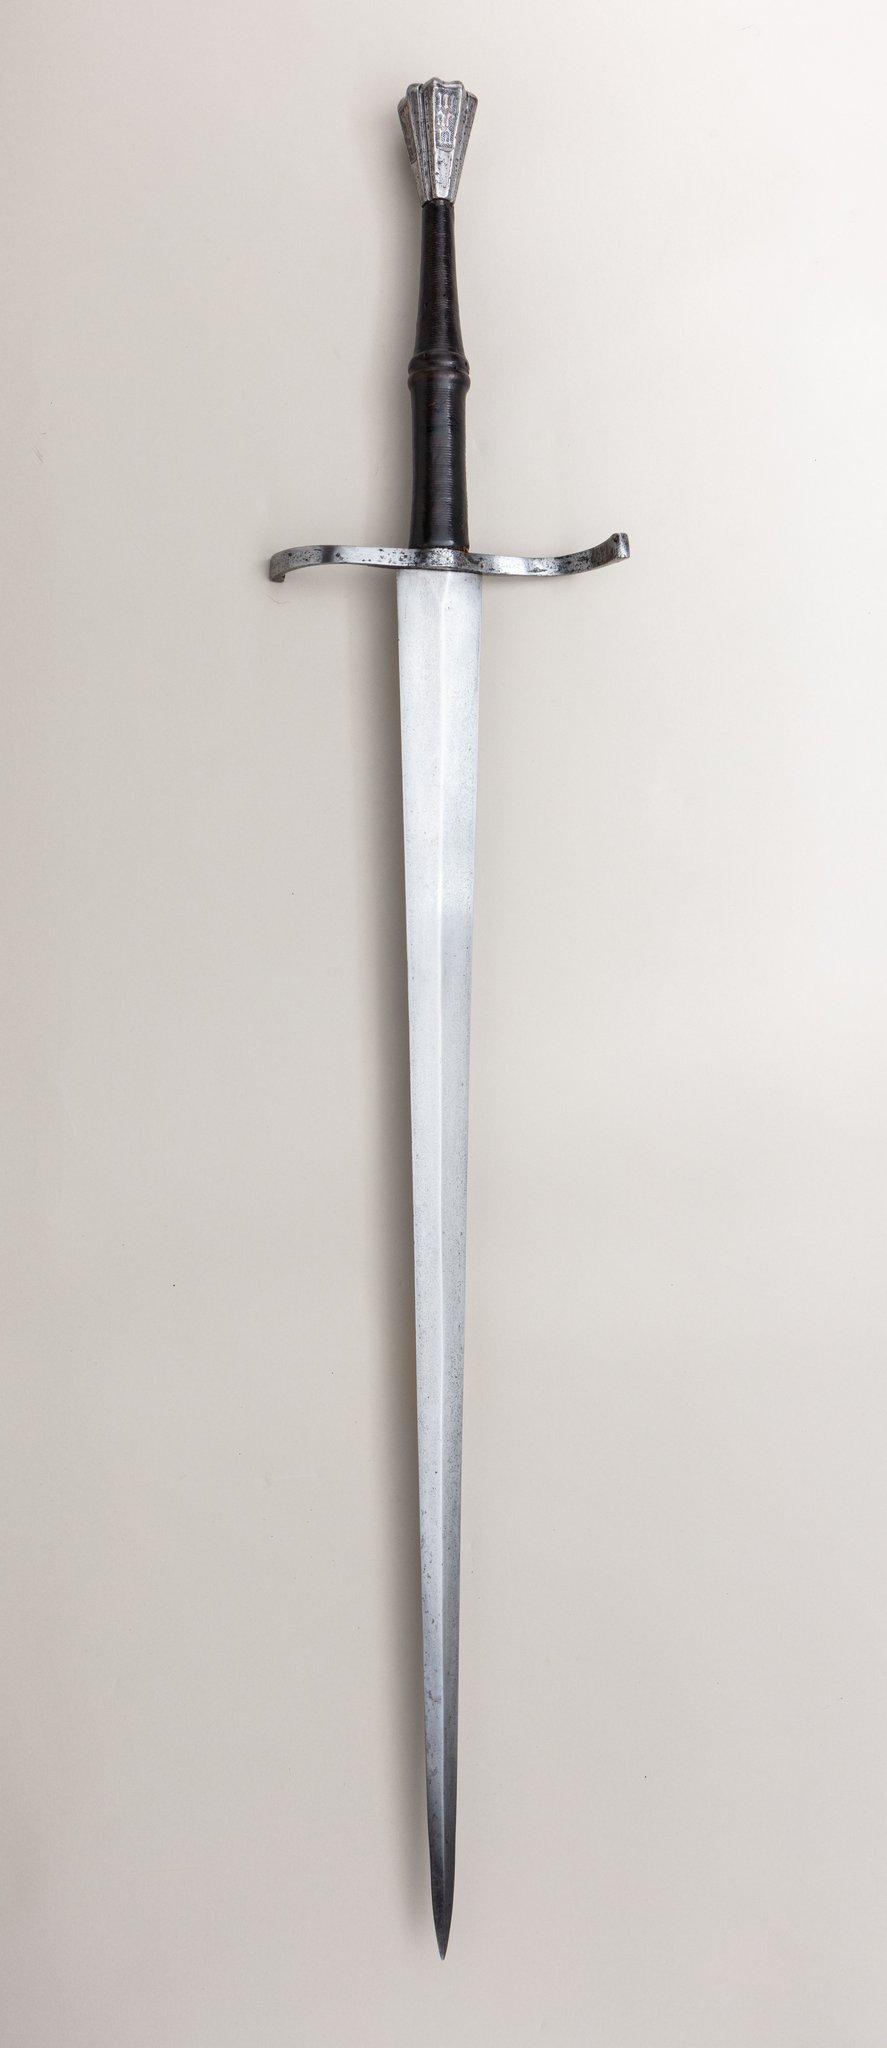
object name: sword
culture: british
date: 1500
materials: leather, silver, steel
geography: england